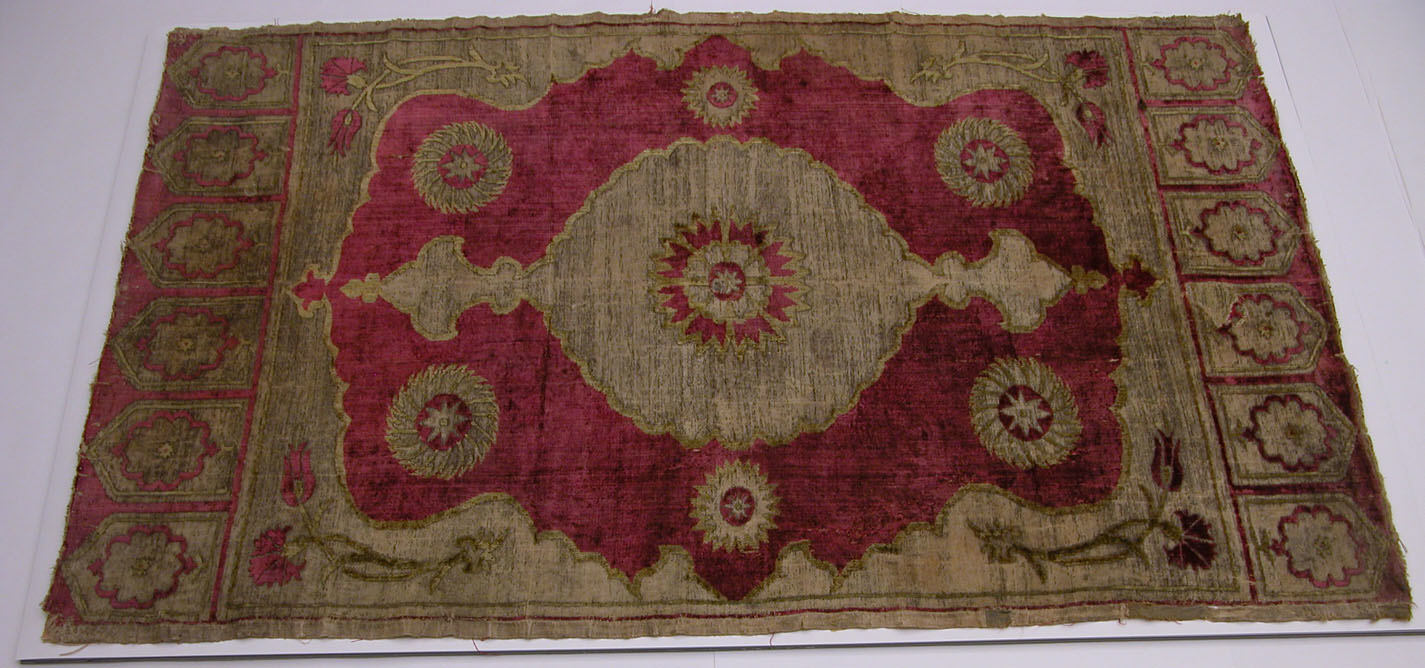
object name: panel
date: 1601-1700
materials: silk, velvet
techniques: brocade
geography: turkey